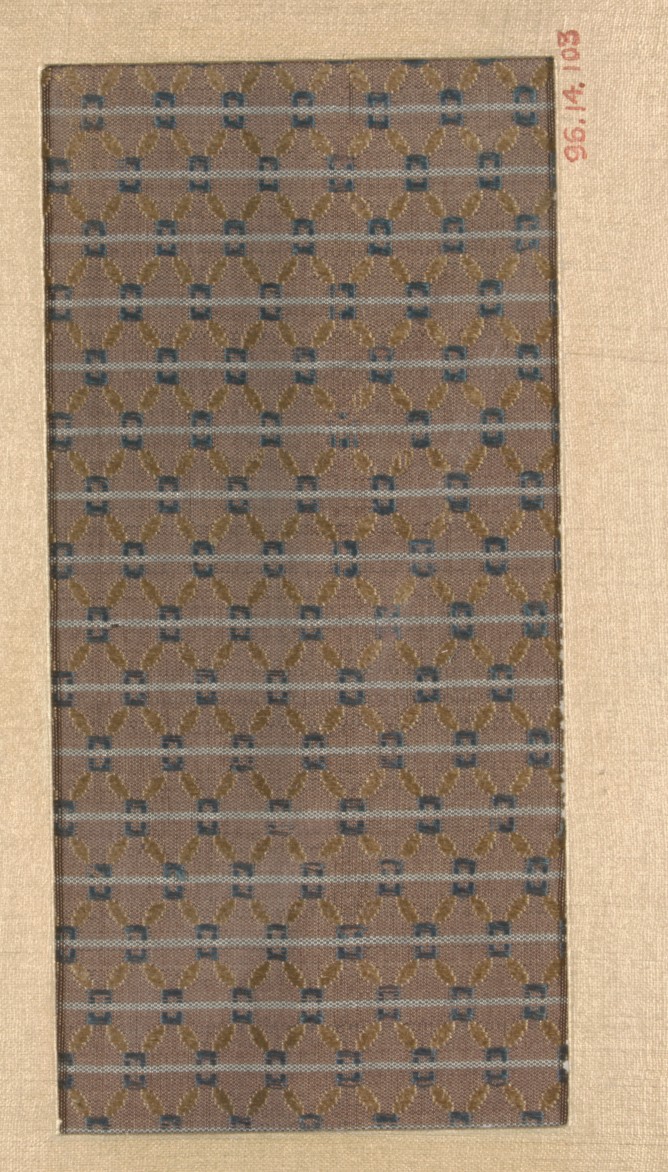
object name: piece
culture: japanese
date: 1701-1900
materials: silk